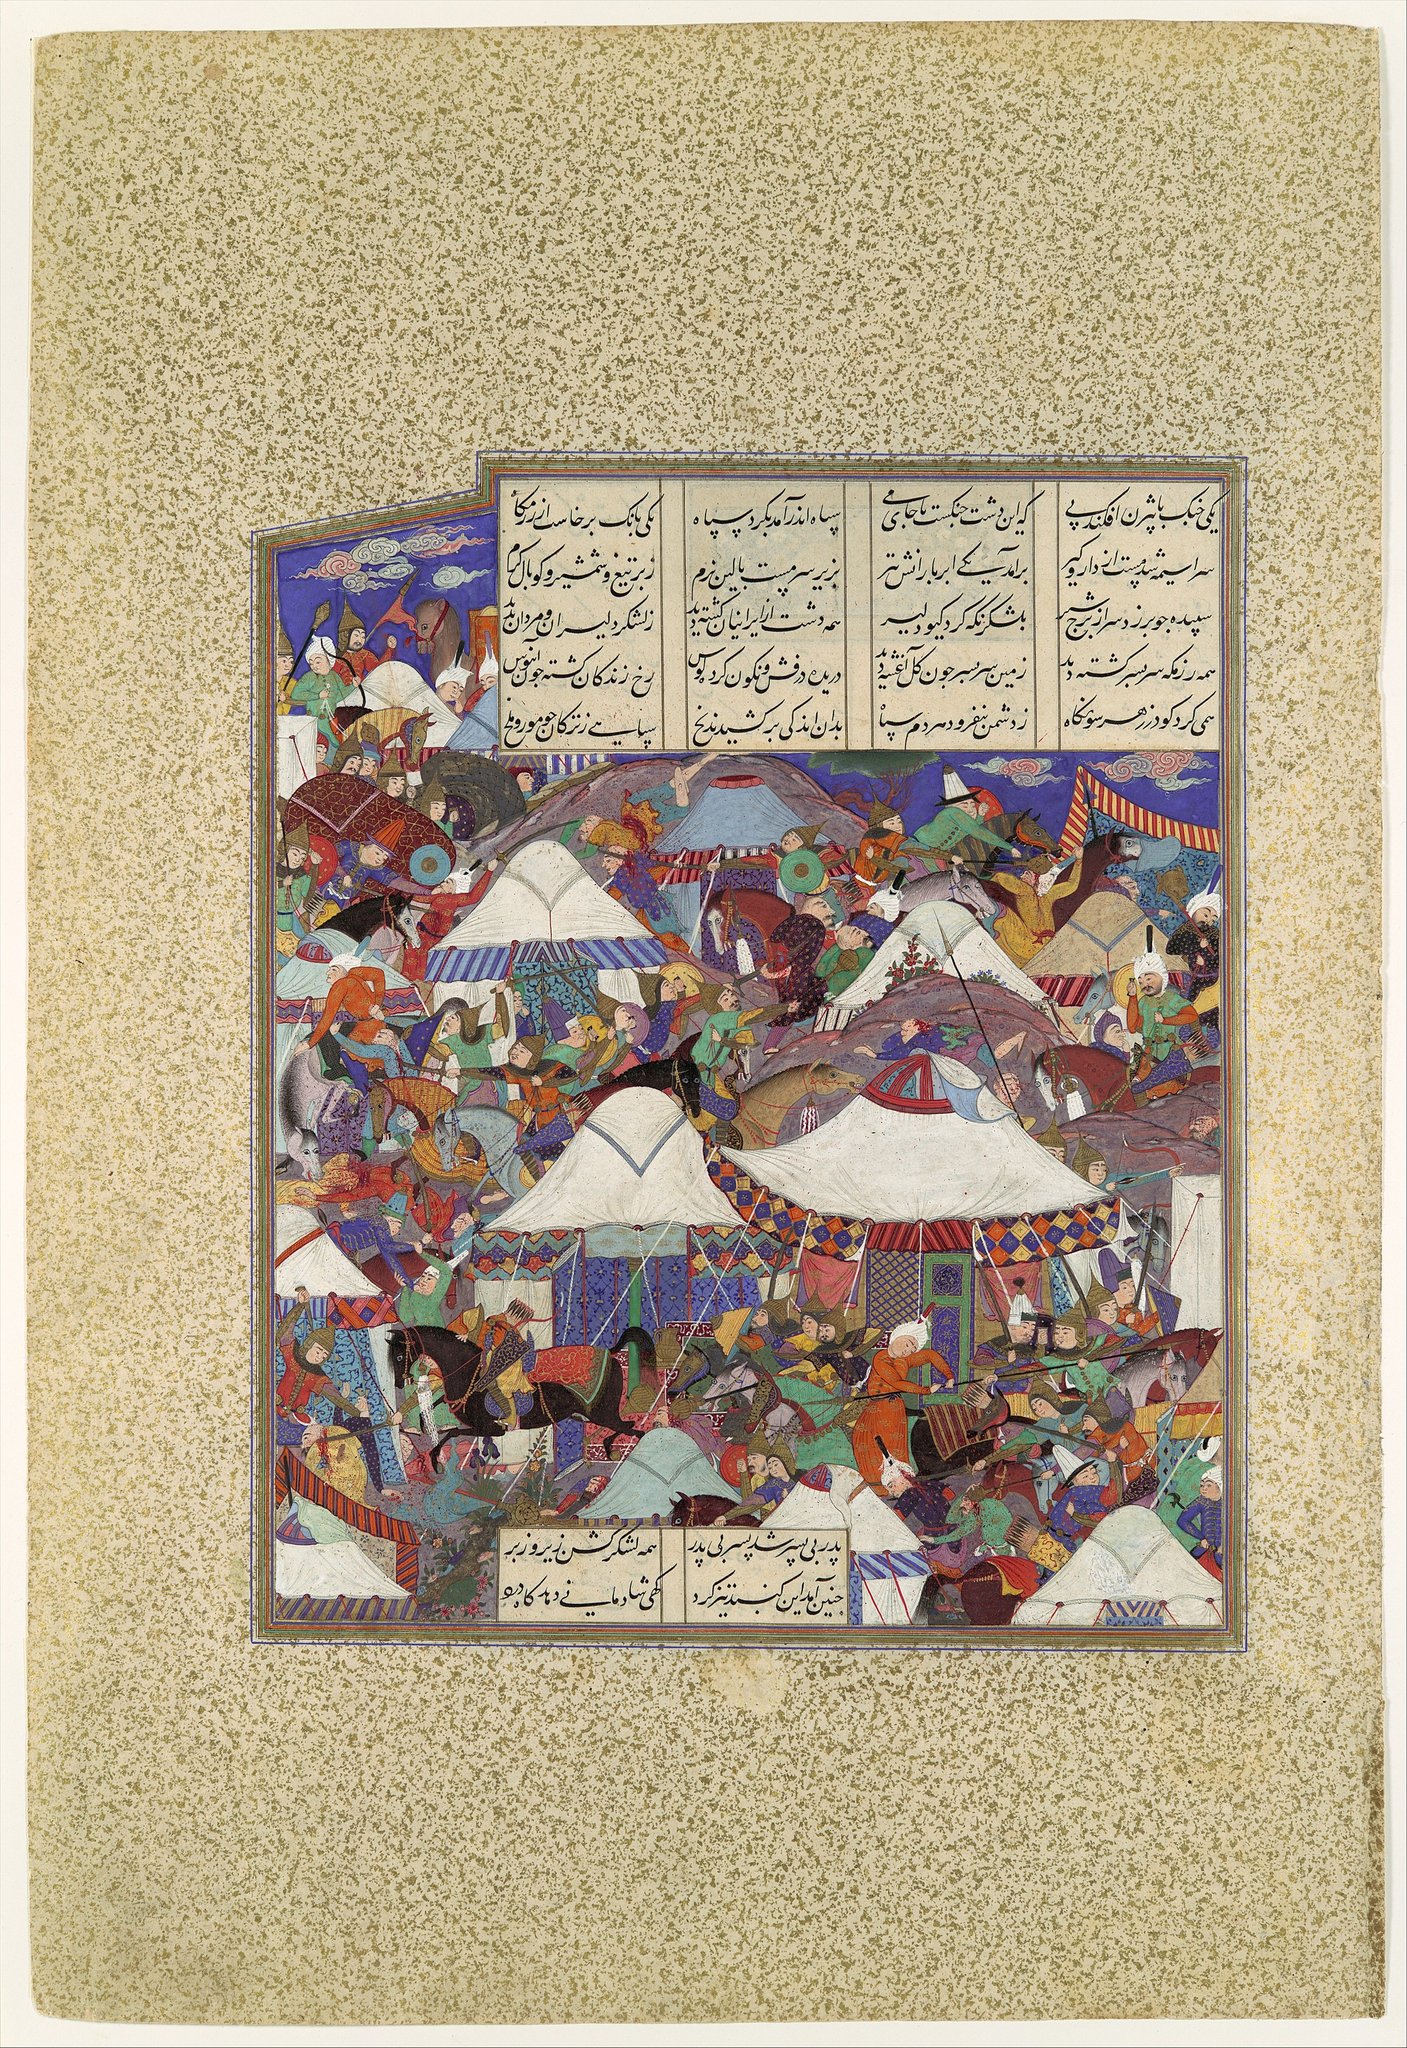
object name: folio from an illustrated manuscript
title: "The Besotted Iranian Camp Attacked by Night", Folio 241r from the Shahnama (Book of Kings) of Shah Tahmasp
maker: abu'l qasim firdausi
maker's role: author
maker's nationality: iranian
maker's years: 935-1020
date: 1525-1530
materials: gold, ink, paper, silver, watercolor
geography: iran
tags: tents,battles,men,horses